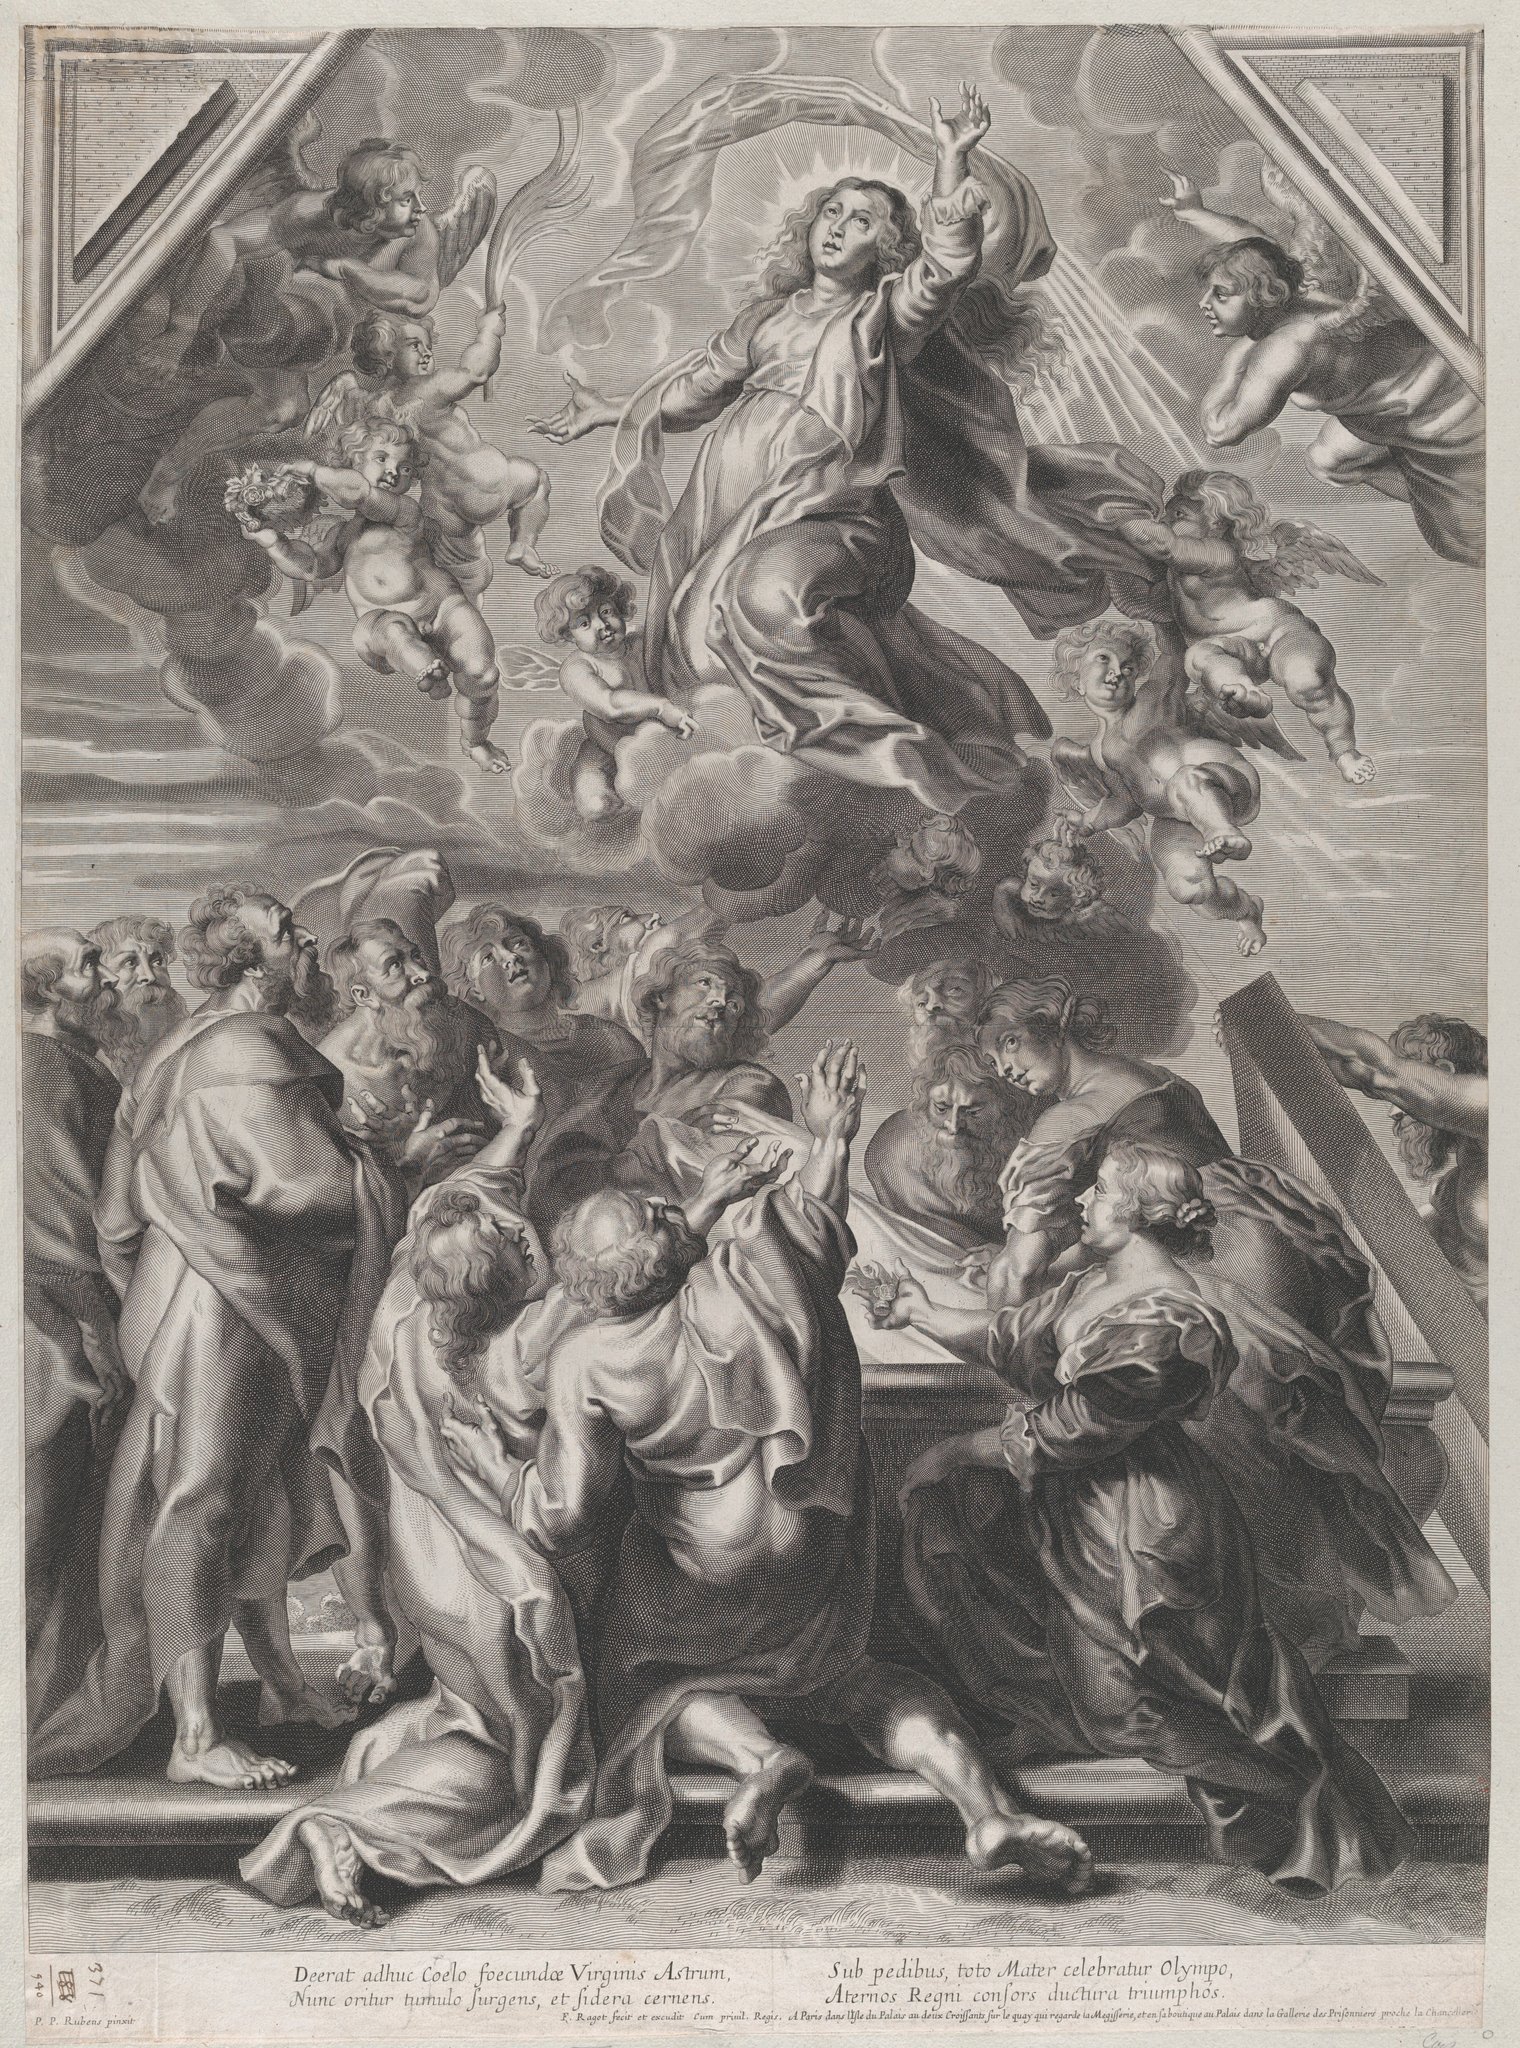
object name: print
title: The Assumption of the Virgin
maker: françois ragot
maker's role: artist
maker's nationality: french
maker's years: 1638-1670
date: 1634-1700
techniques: engraving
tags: men,women,angels,virgin mary,assumption of the virgin